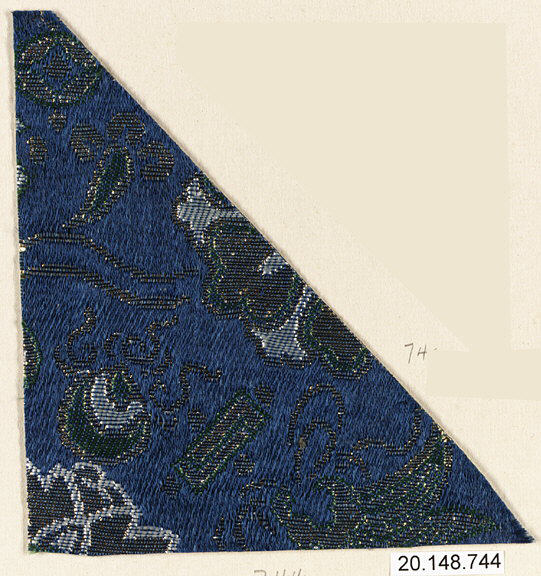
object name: piece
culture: japanese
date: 1601-1700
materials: silk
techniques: compound weave